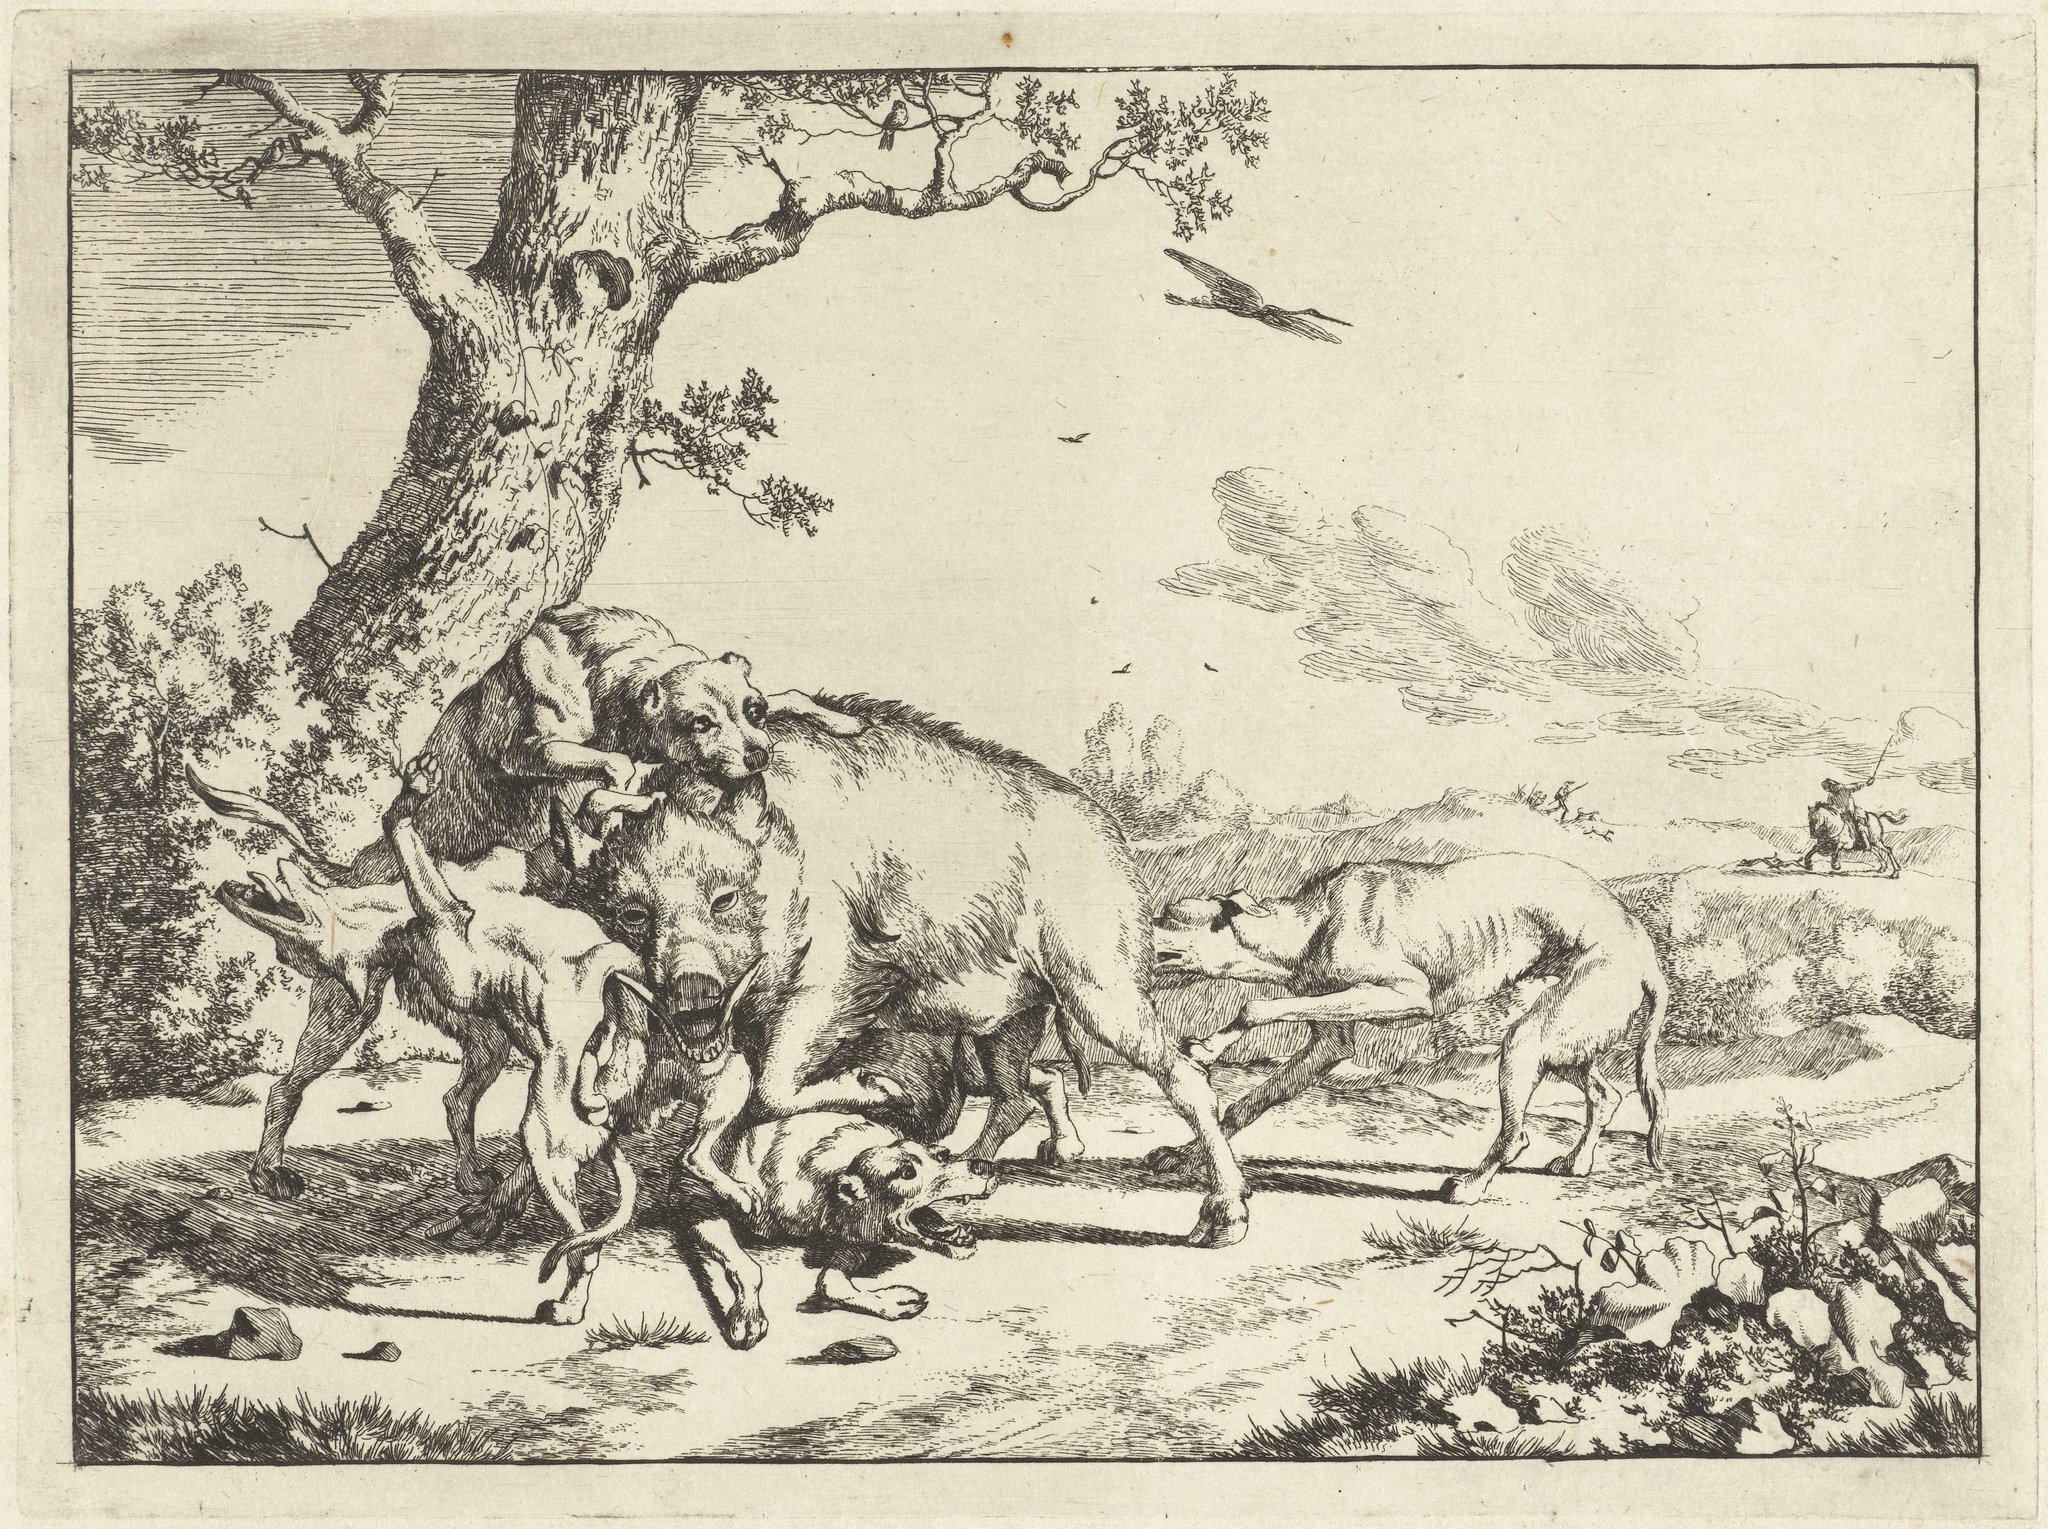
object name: print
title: Zwijn aangevallen door vier jachthonden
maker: marcus de bye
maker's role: print maker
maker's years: 1639-1688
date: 1657-1677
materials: paper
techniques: etching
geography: the hague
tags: hunting, chase, hunting dogs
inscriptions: collector's mark: Lugt 240